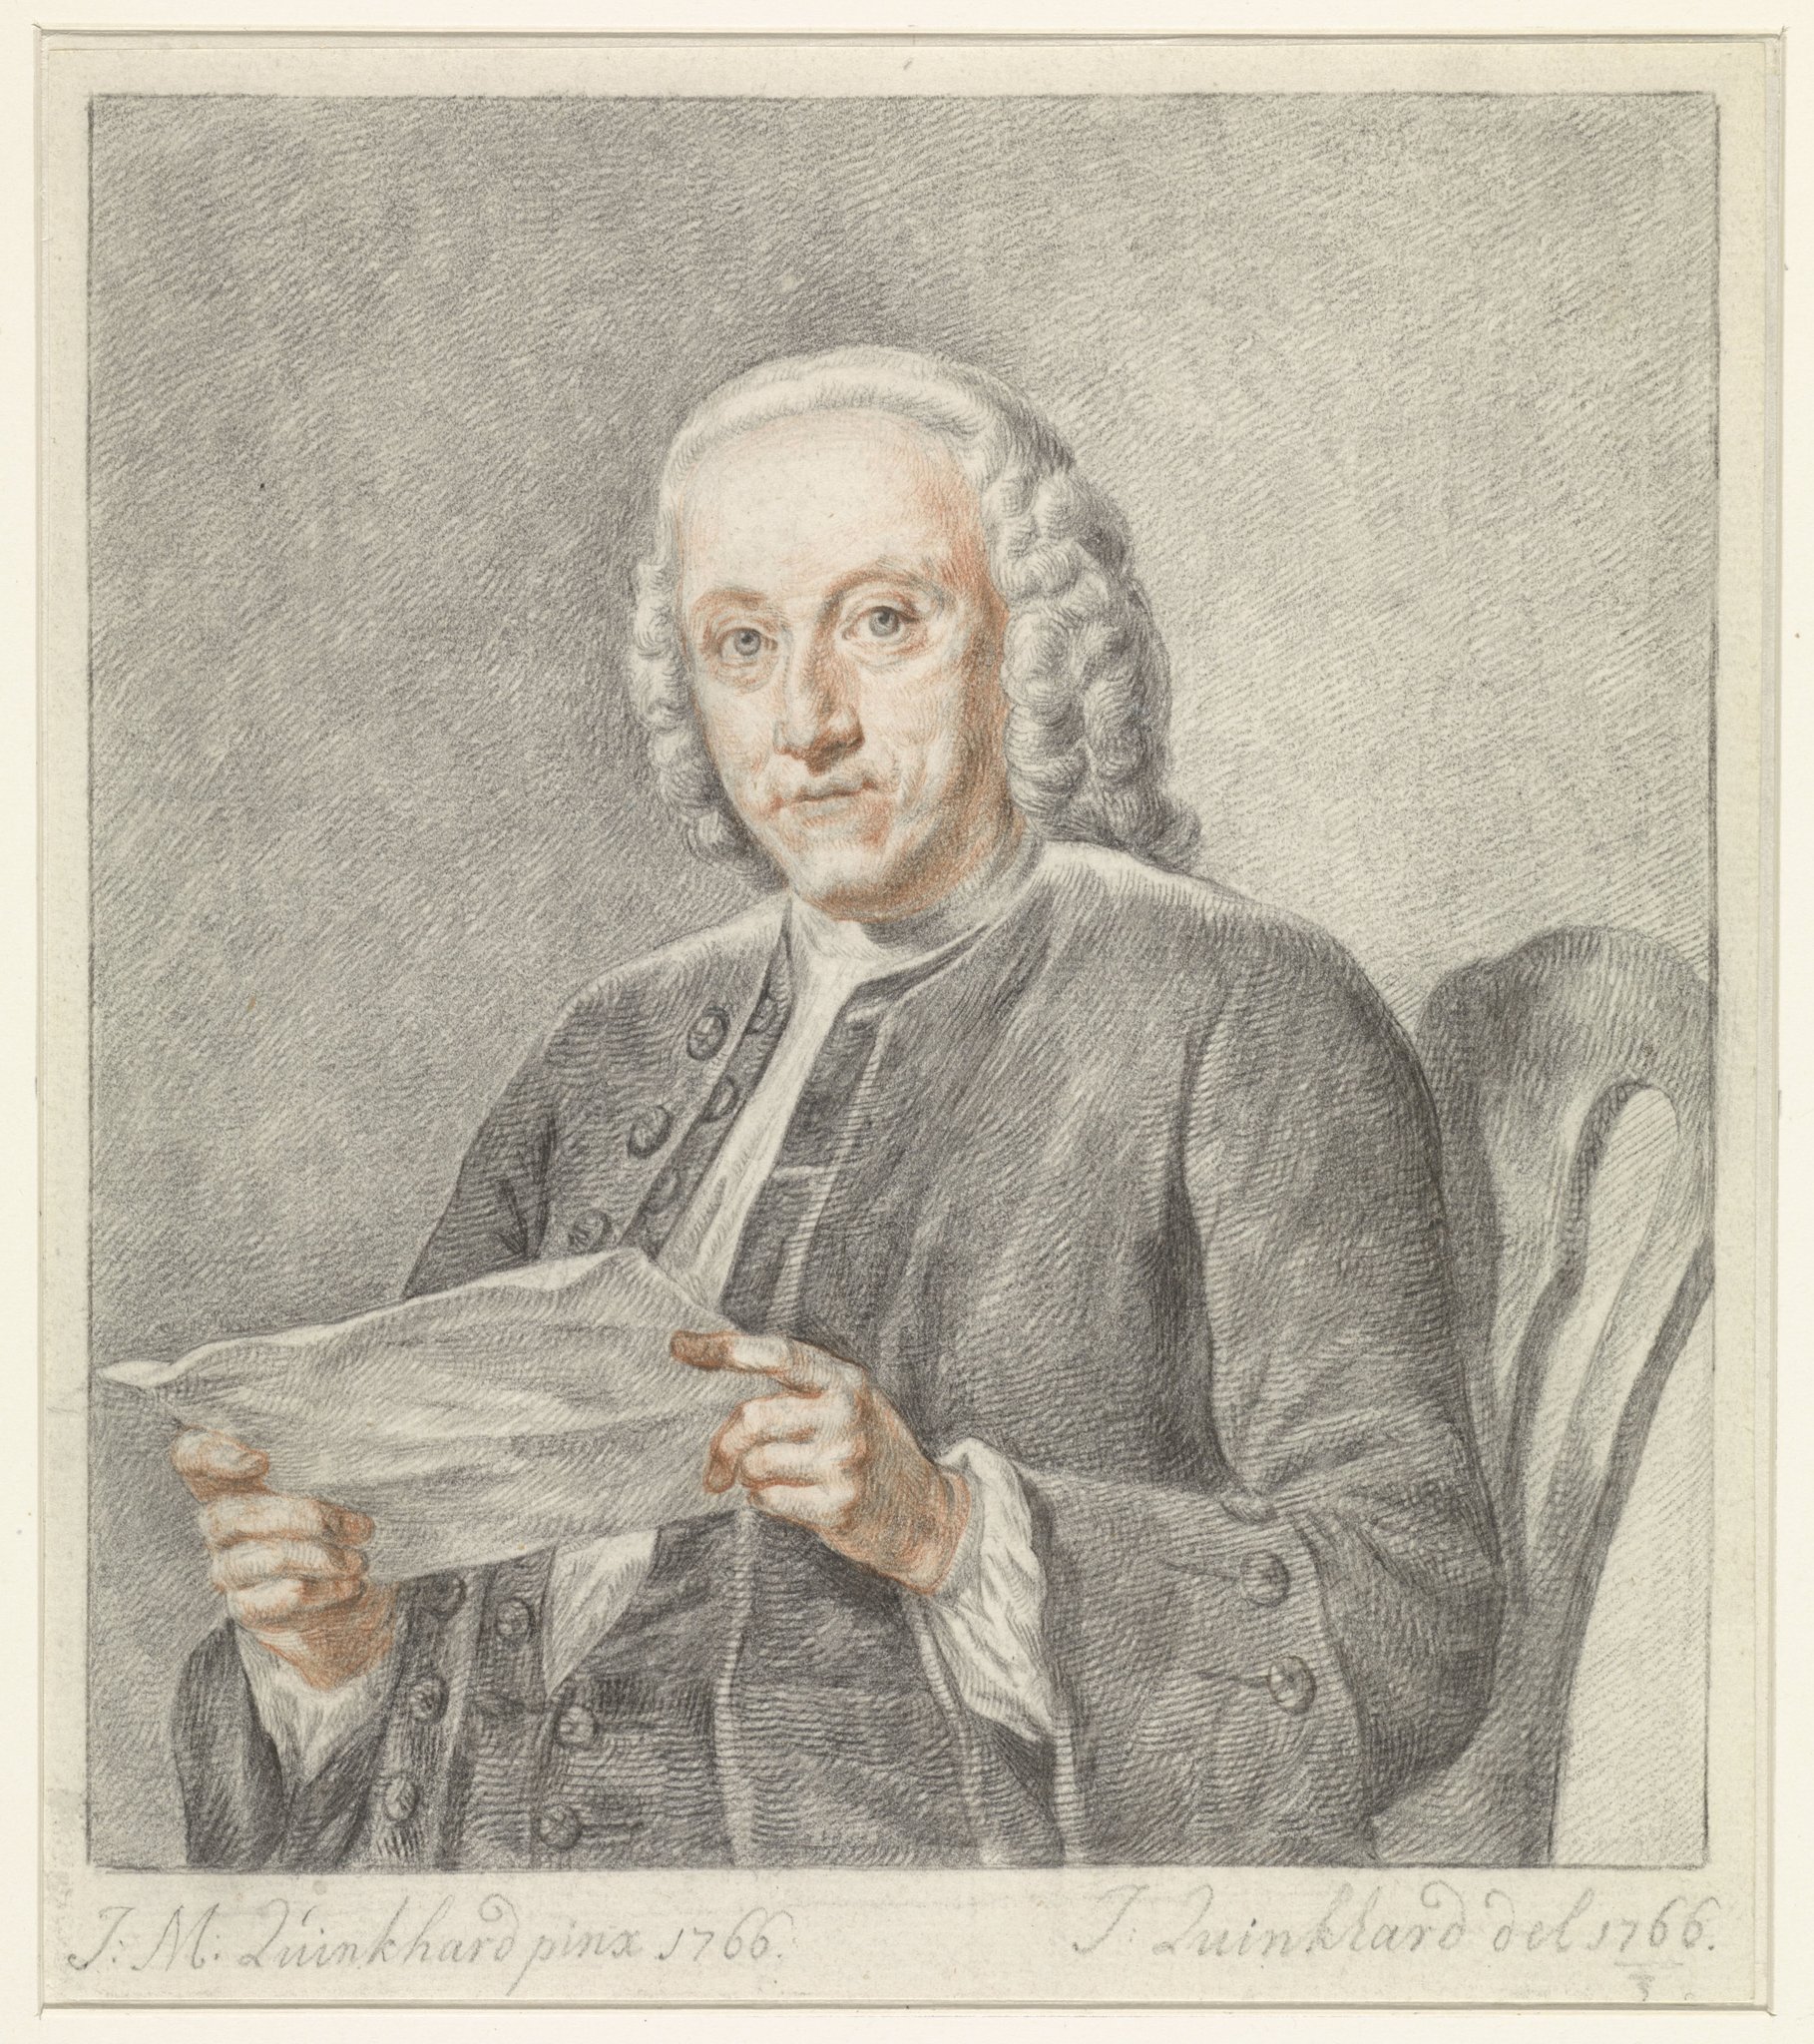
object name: drawing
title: Portret van Hendrik Busserus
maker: julius henricus quinkhard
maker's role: draughtsman, painter, print maker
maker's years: 1734-1795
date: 1766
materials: chalk, paper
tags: hendrik busserus, historical persons, portrait, self-portrait of painter, portrait, self-portrait of artist, portrait, self-portrait of draughtsman